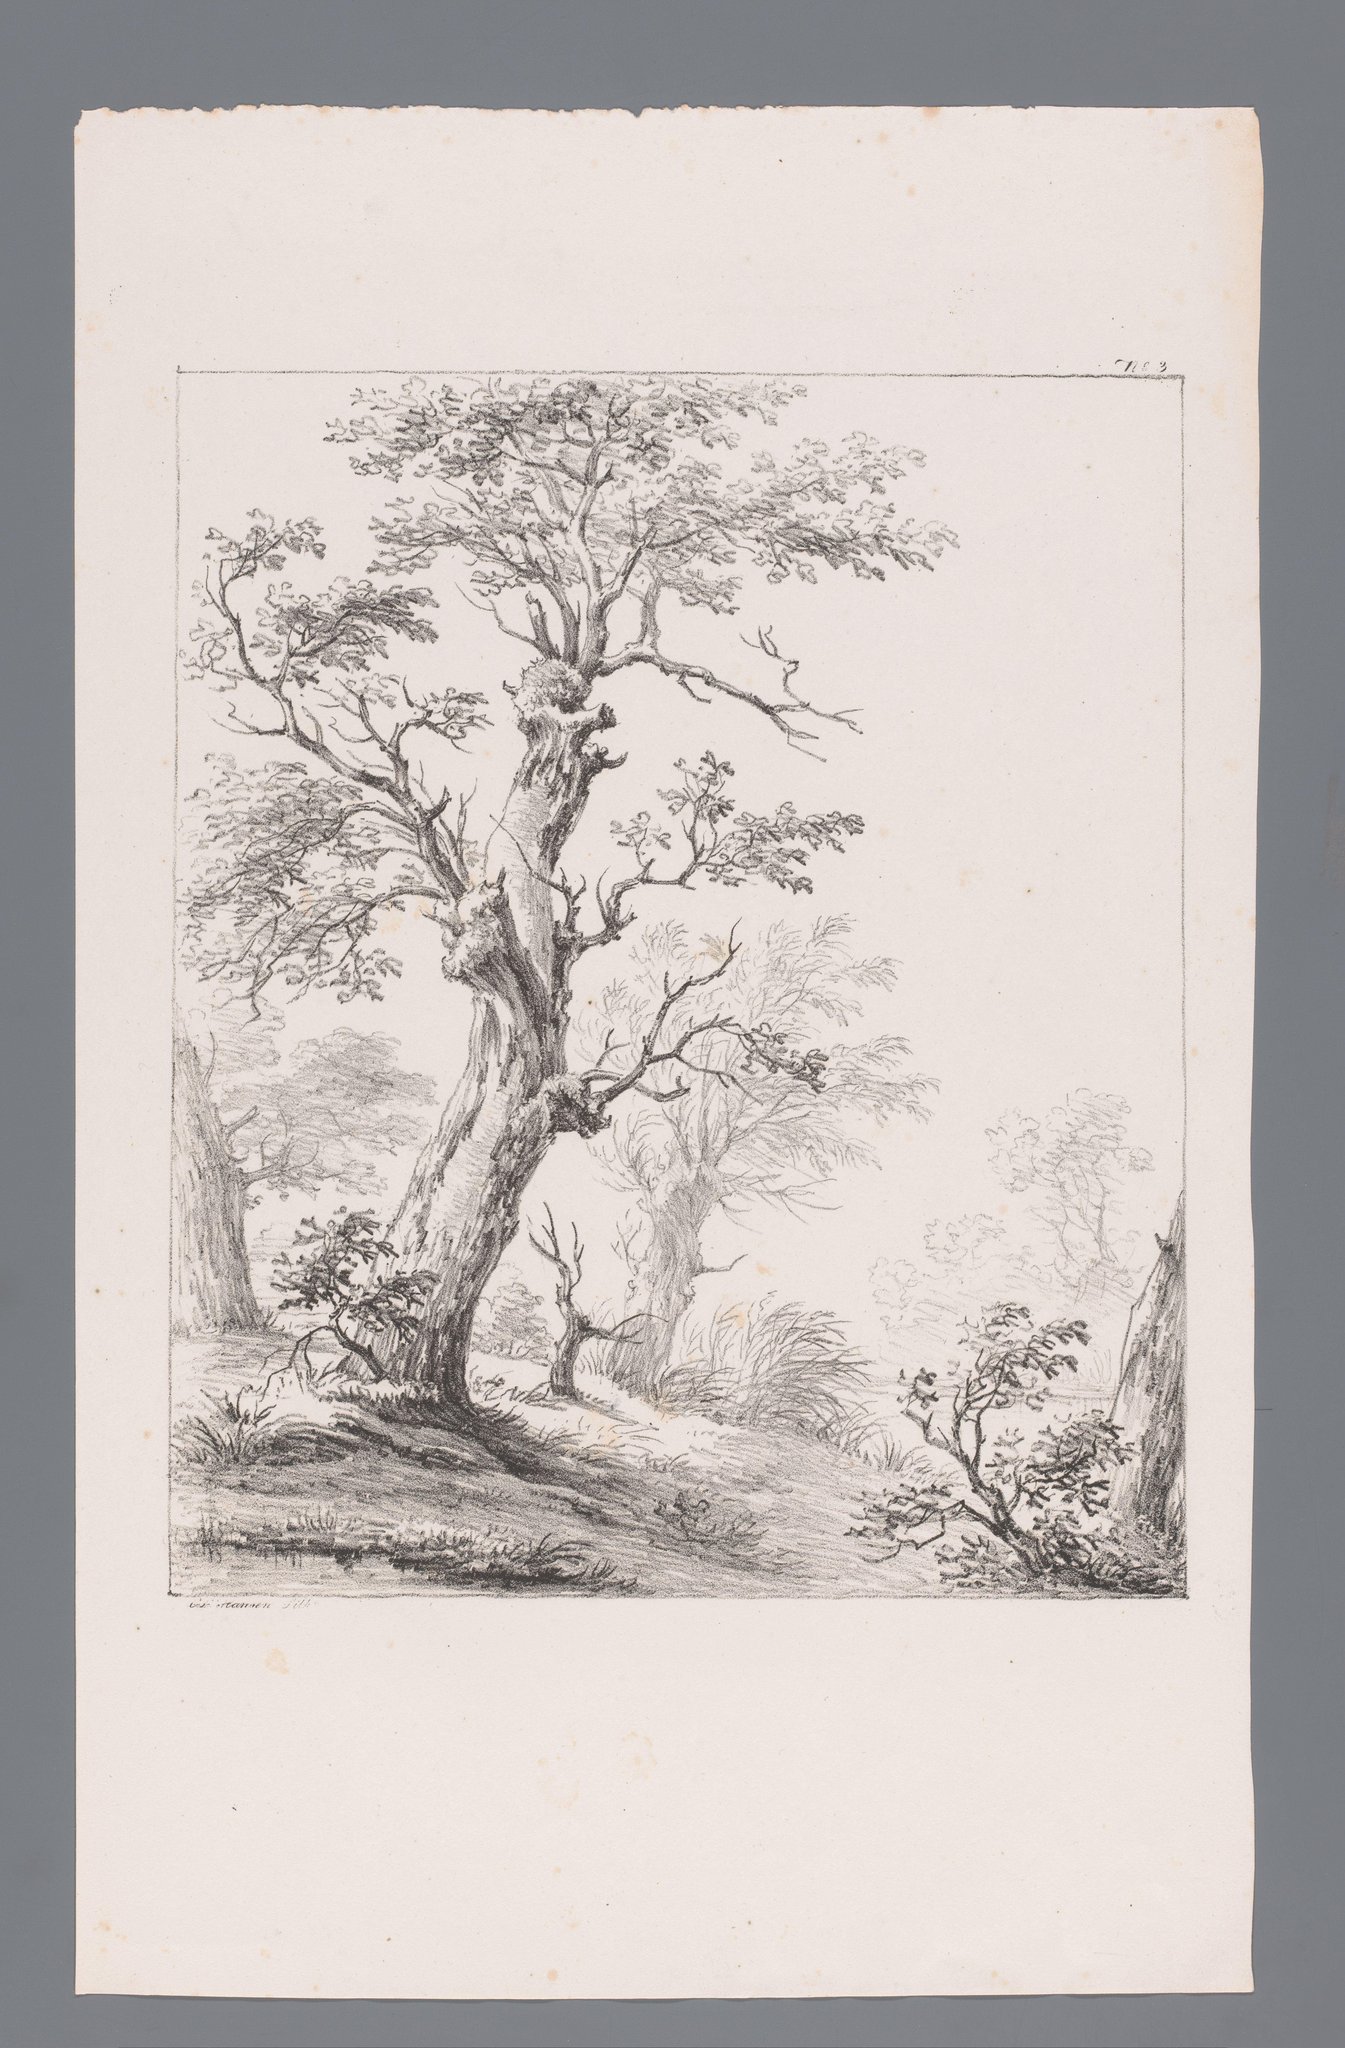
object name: print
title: Landschap studien naar de natuur getekend en op steen gebracht door C.L. Hansen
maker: carel lodewijk hansen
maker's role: draughtsman, painter, print maker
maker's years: 1765-1840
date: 1809-1840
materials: paper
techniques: lithograph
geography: netherlands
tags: trees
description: Genummerd rechtsboven: No. 3. Maakt deel uit van een omslag met zes prenten.